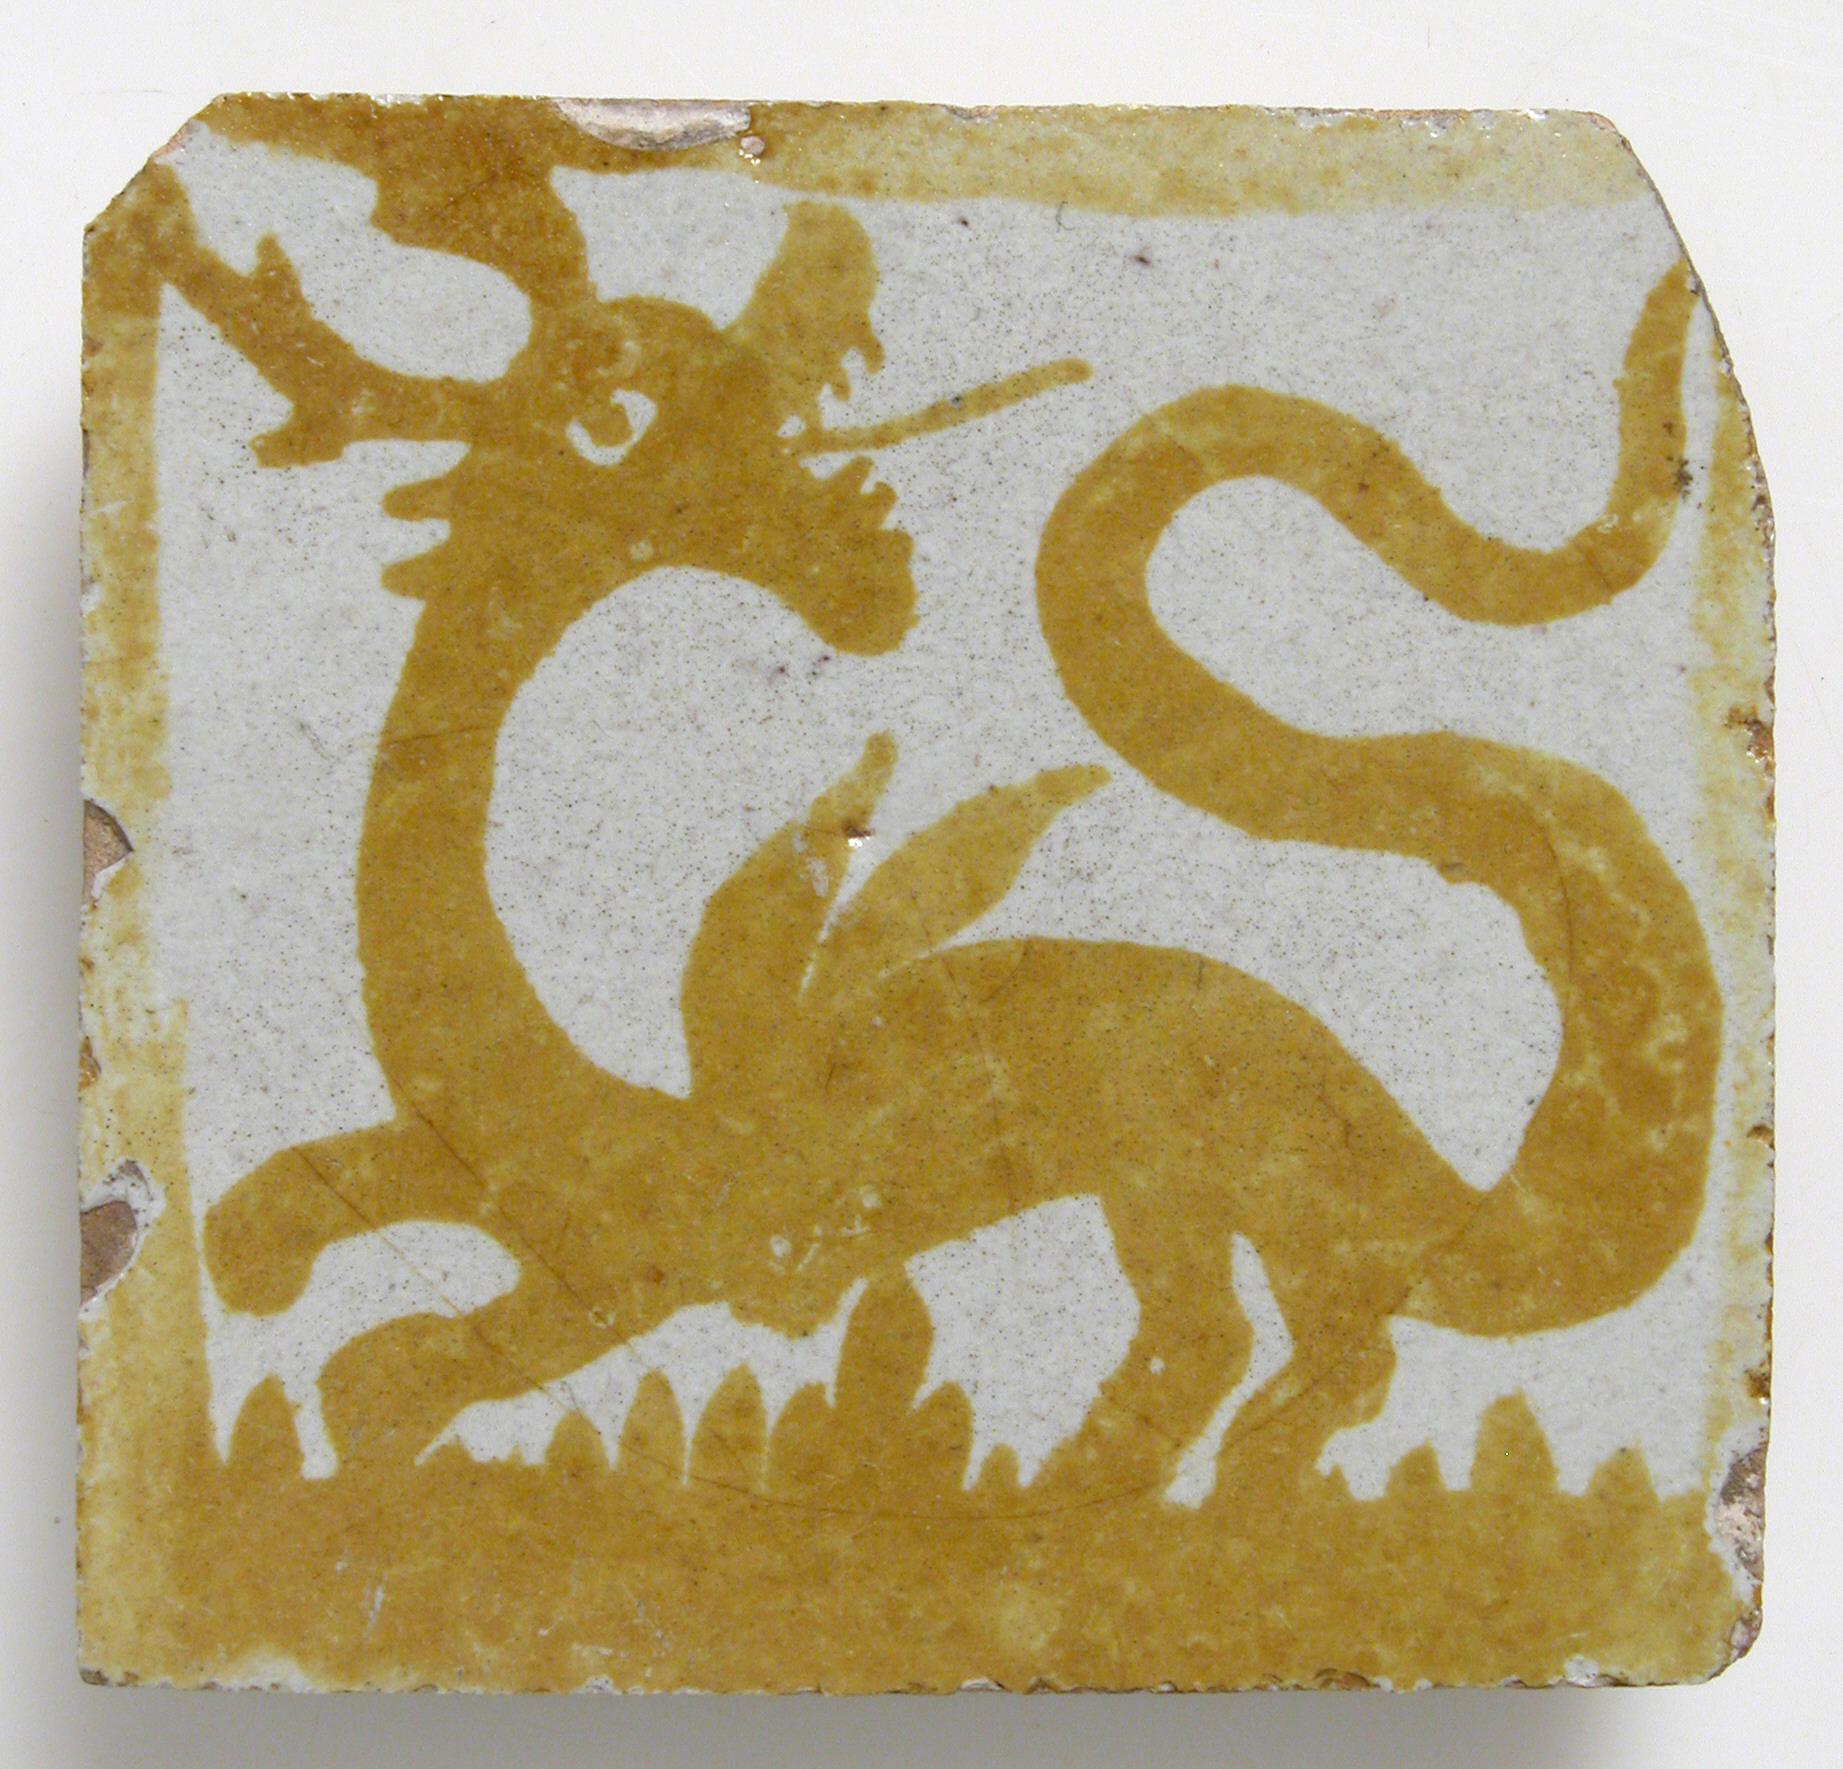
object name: tile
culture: spanish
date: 1201-1300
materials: earthenware, glaze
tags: dragons